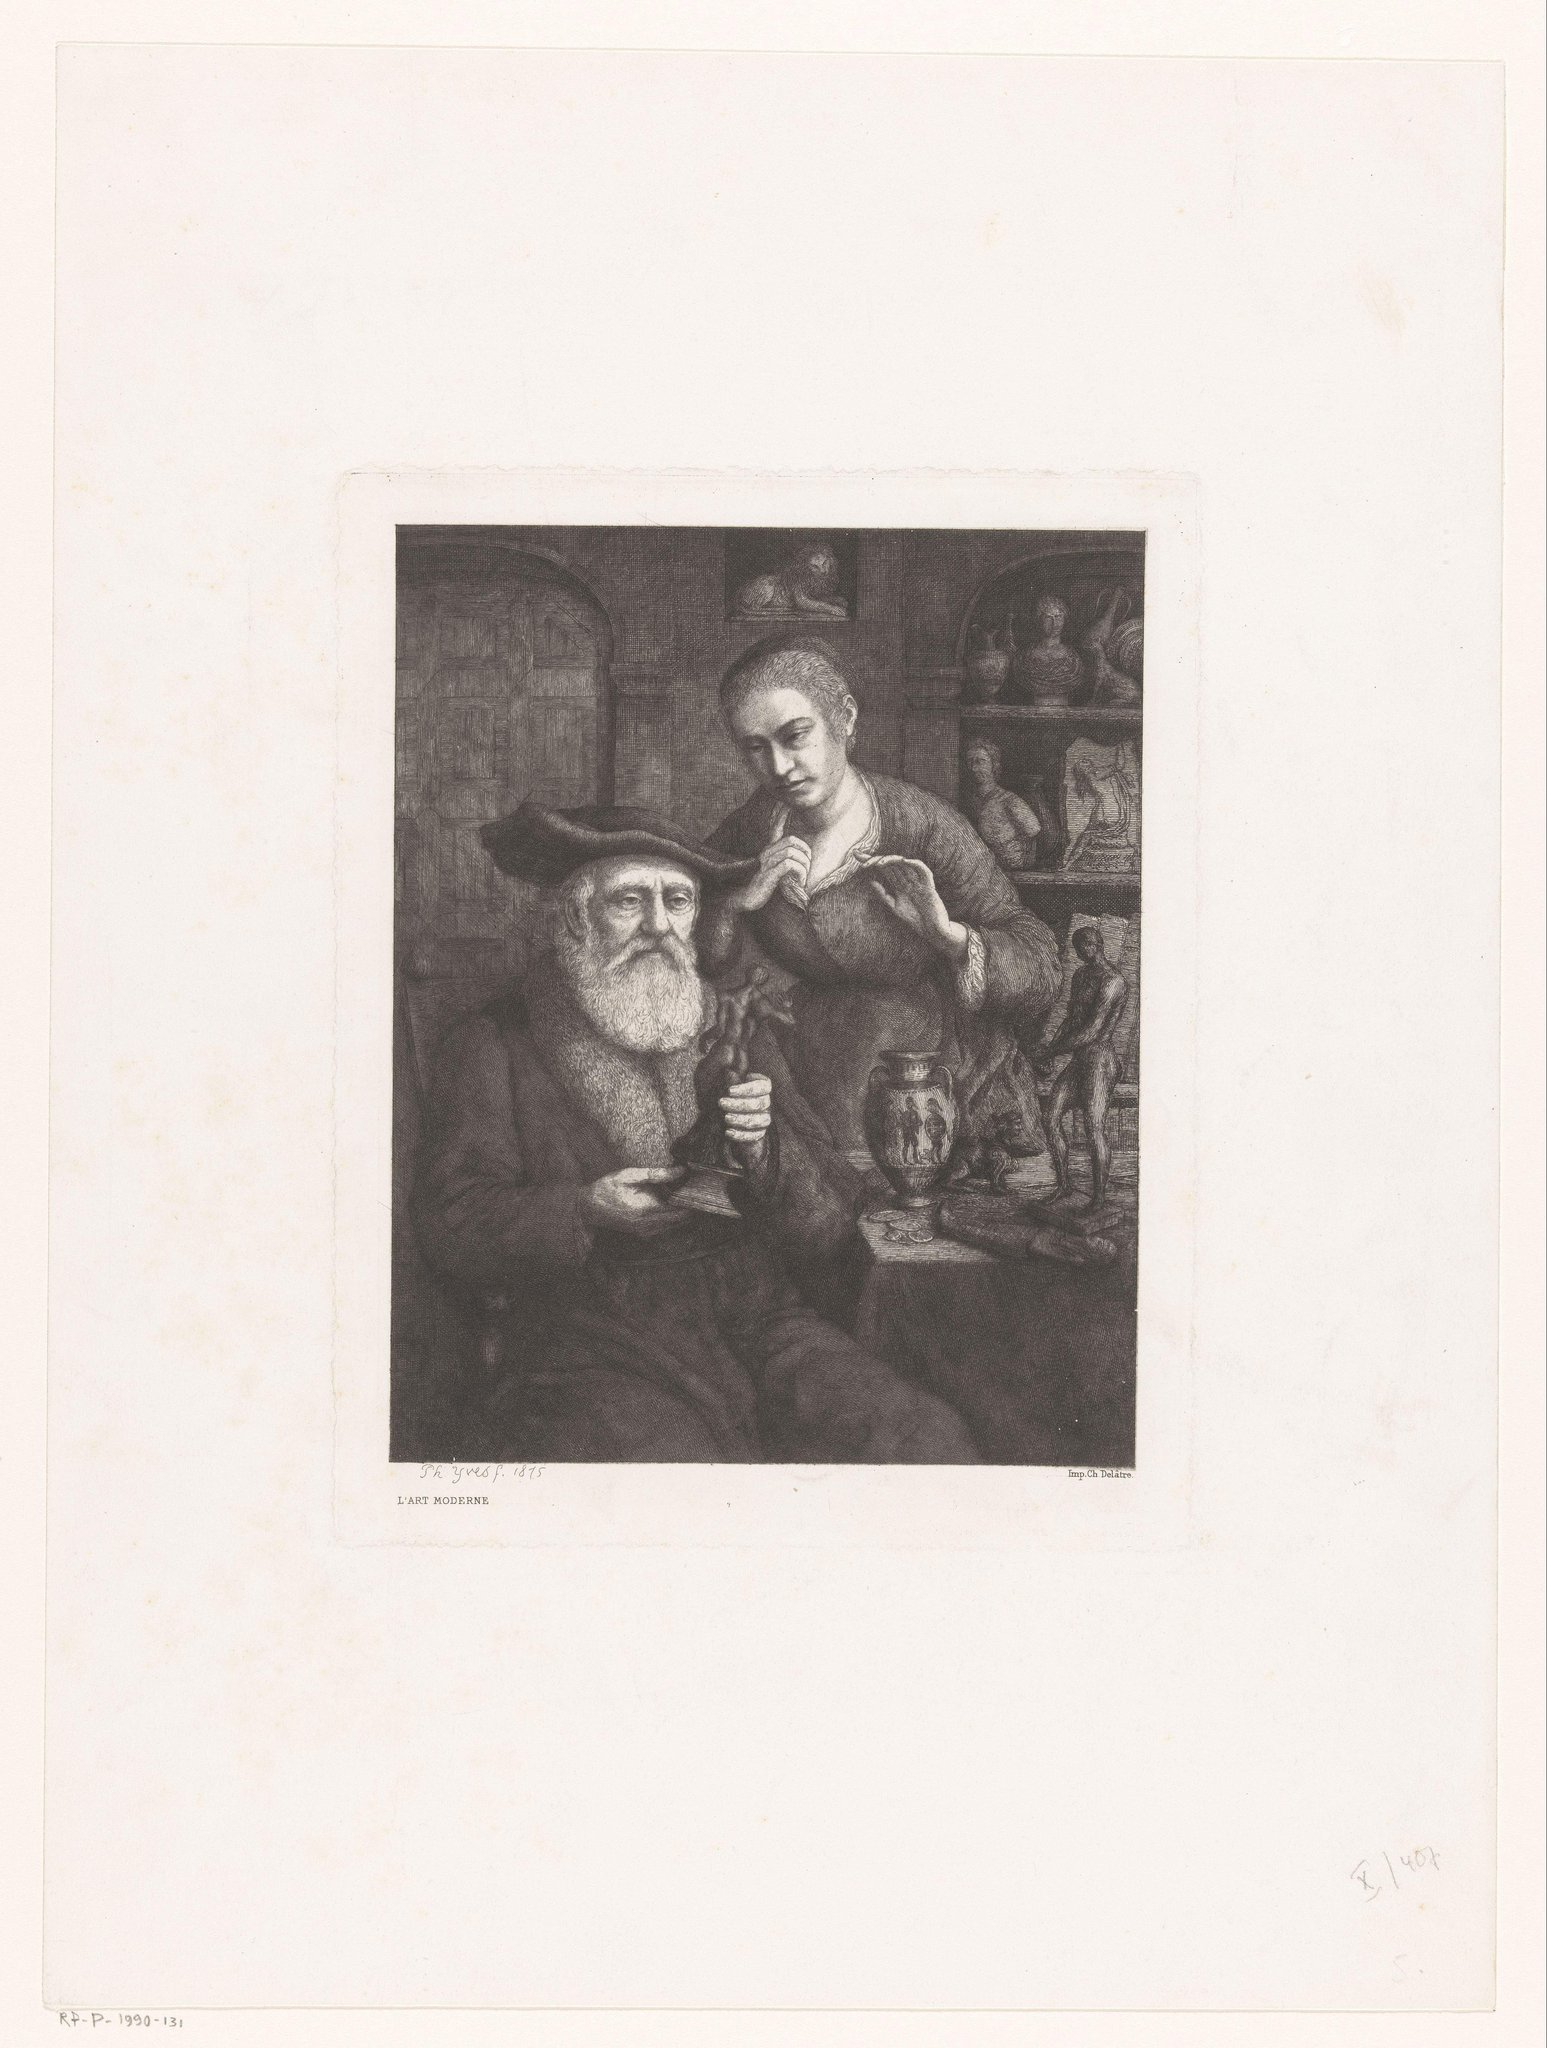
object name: print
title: Interieur met een zittende man en een staande vrouw aan tafel, omgeven door kunstobjecten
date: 1875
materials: paper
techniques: etching, intaglio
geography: france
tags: piece of sculpture, reproduction of a piece of sculpture, interior of the house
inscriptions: collector's mark: Lugt 2228